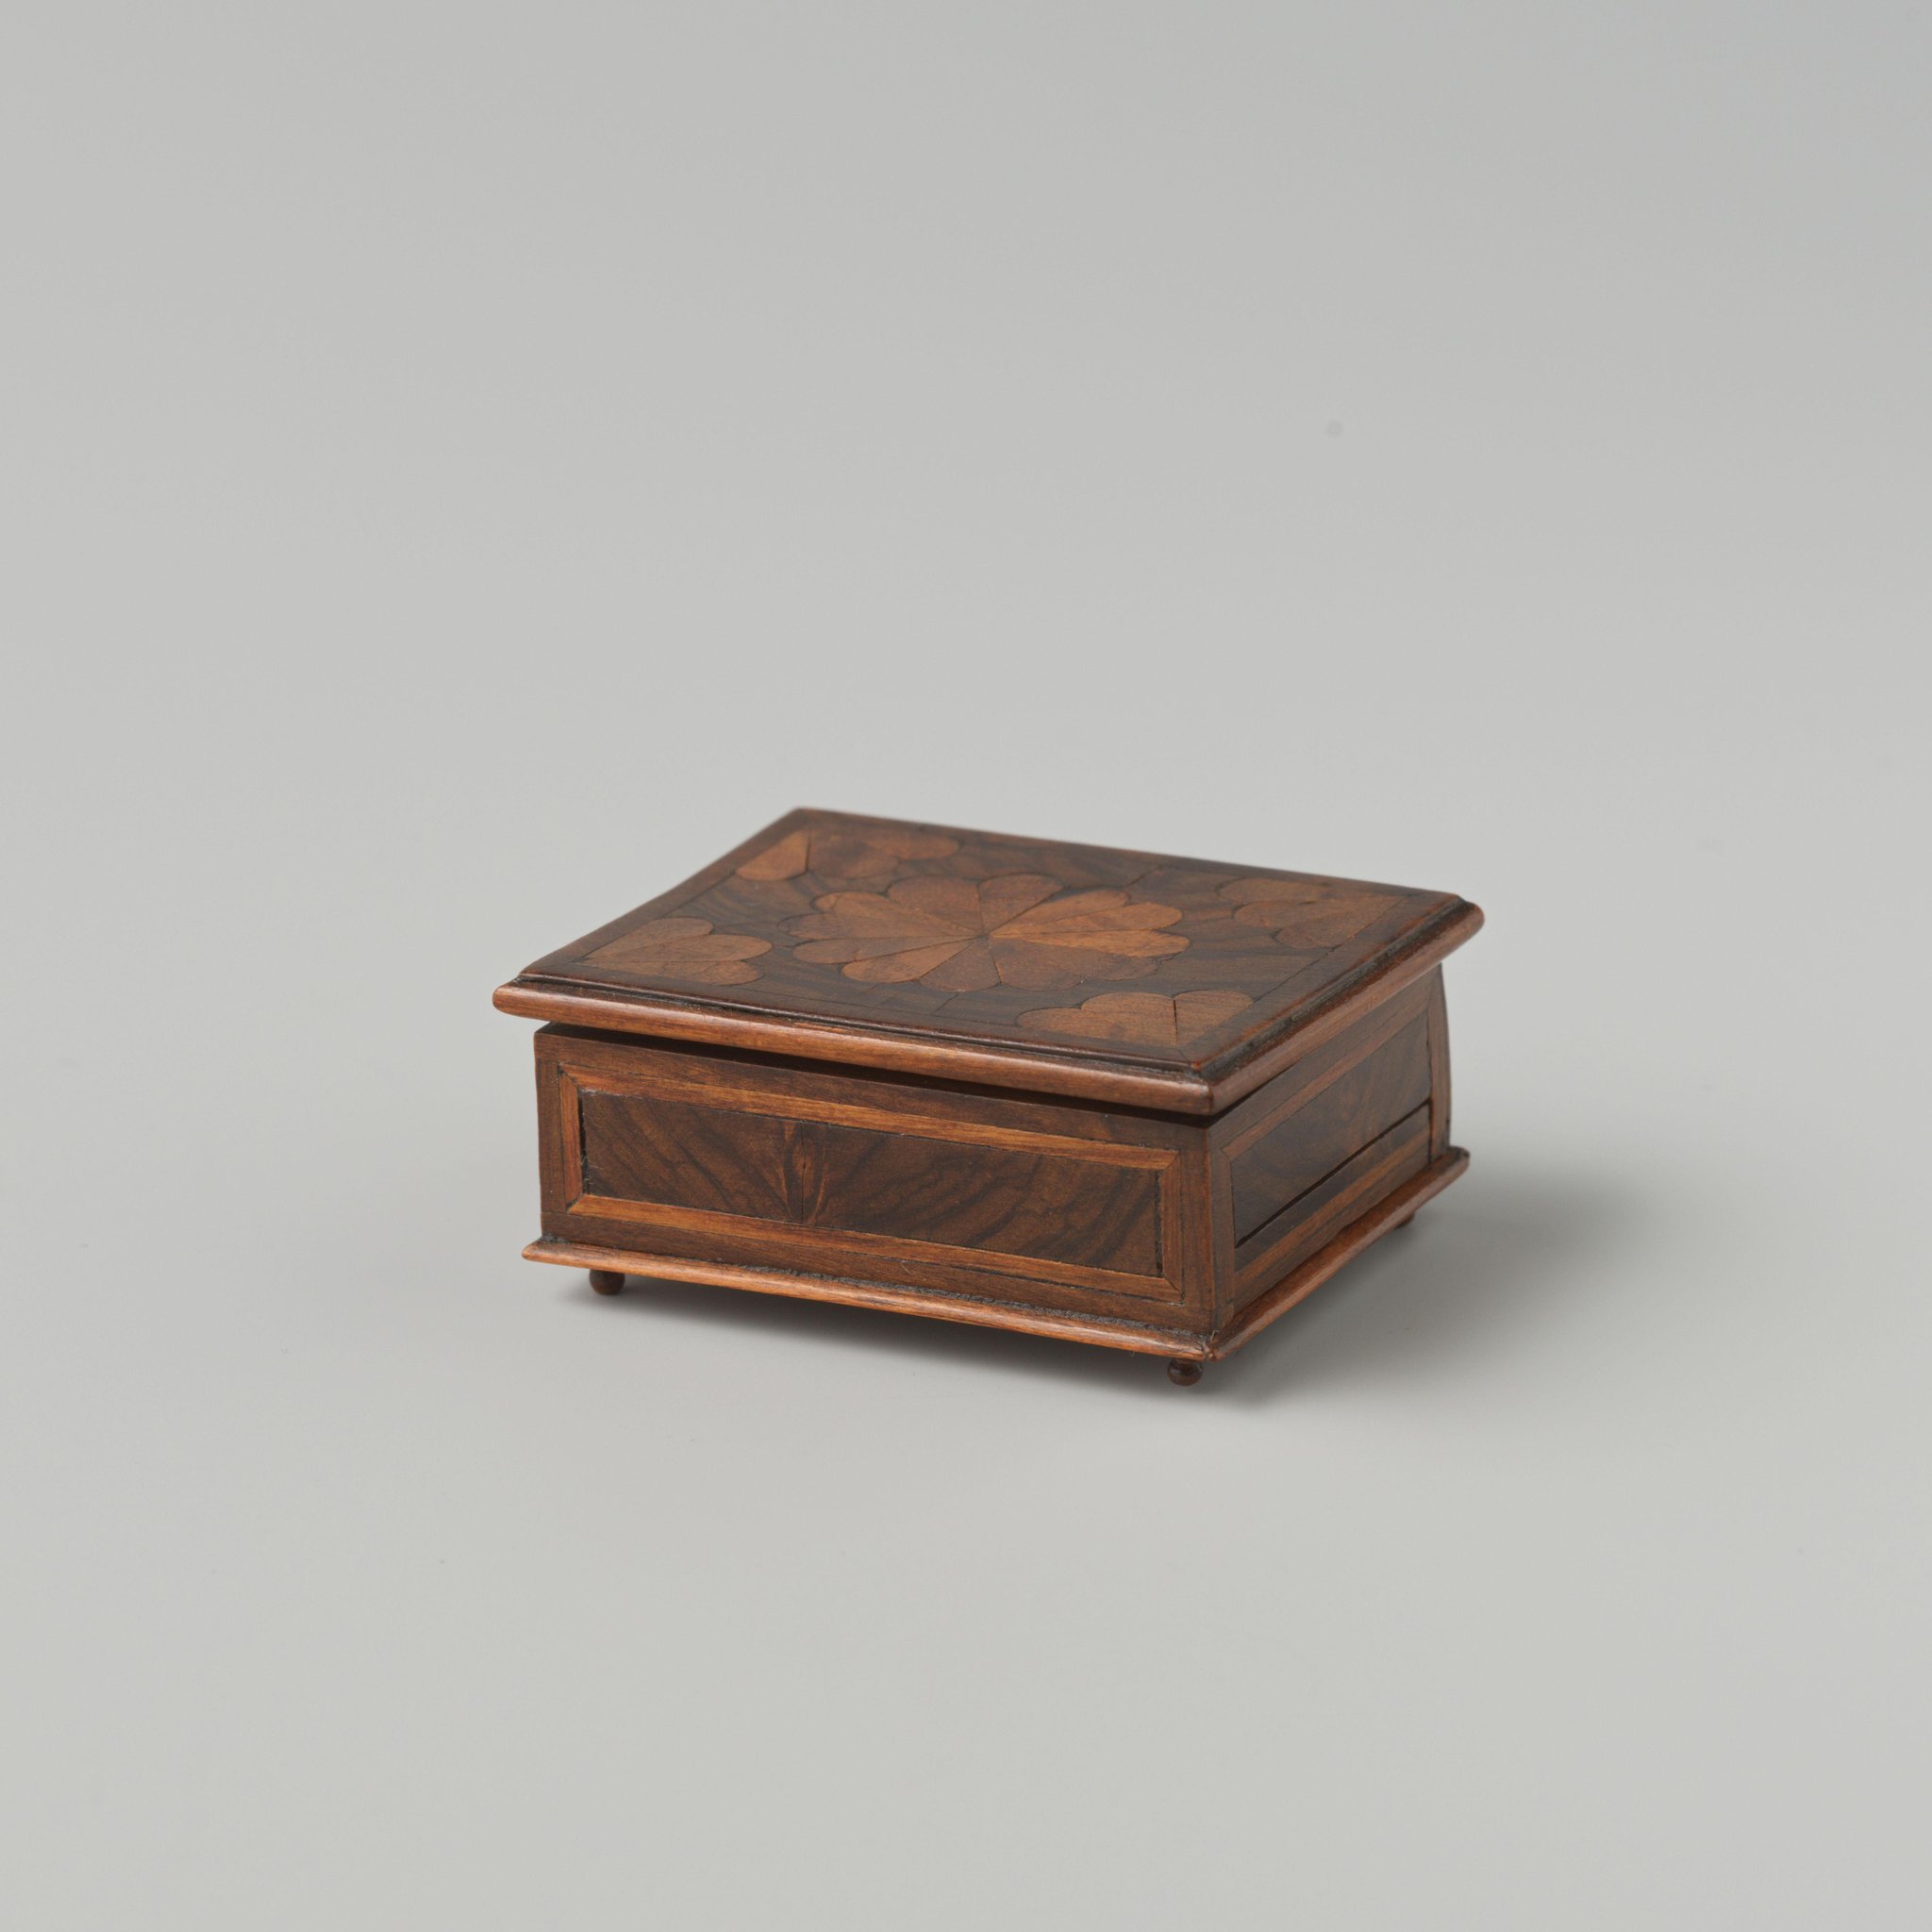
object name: housewife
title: Garendoos van cederhout en geheel beplakt met marqueterie van olijfhout en notenhout, sterpatroon op het deksel; rechthoekig doos op vier bolpootjes met onderin lade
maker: Anonymous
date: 1690-1710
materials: wood, copper, paper, silk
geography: amsterdam